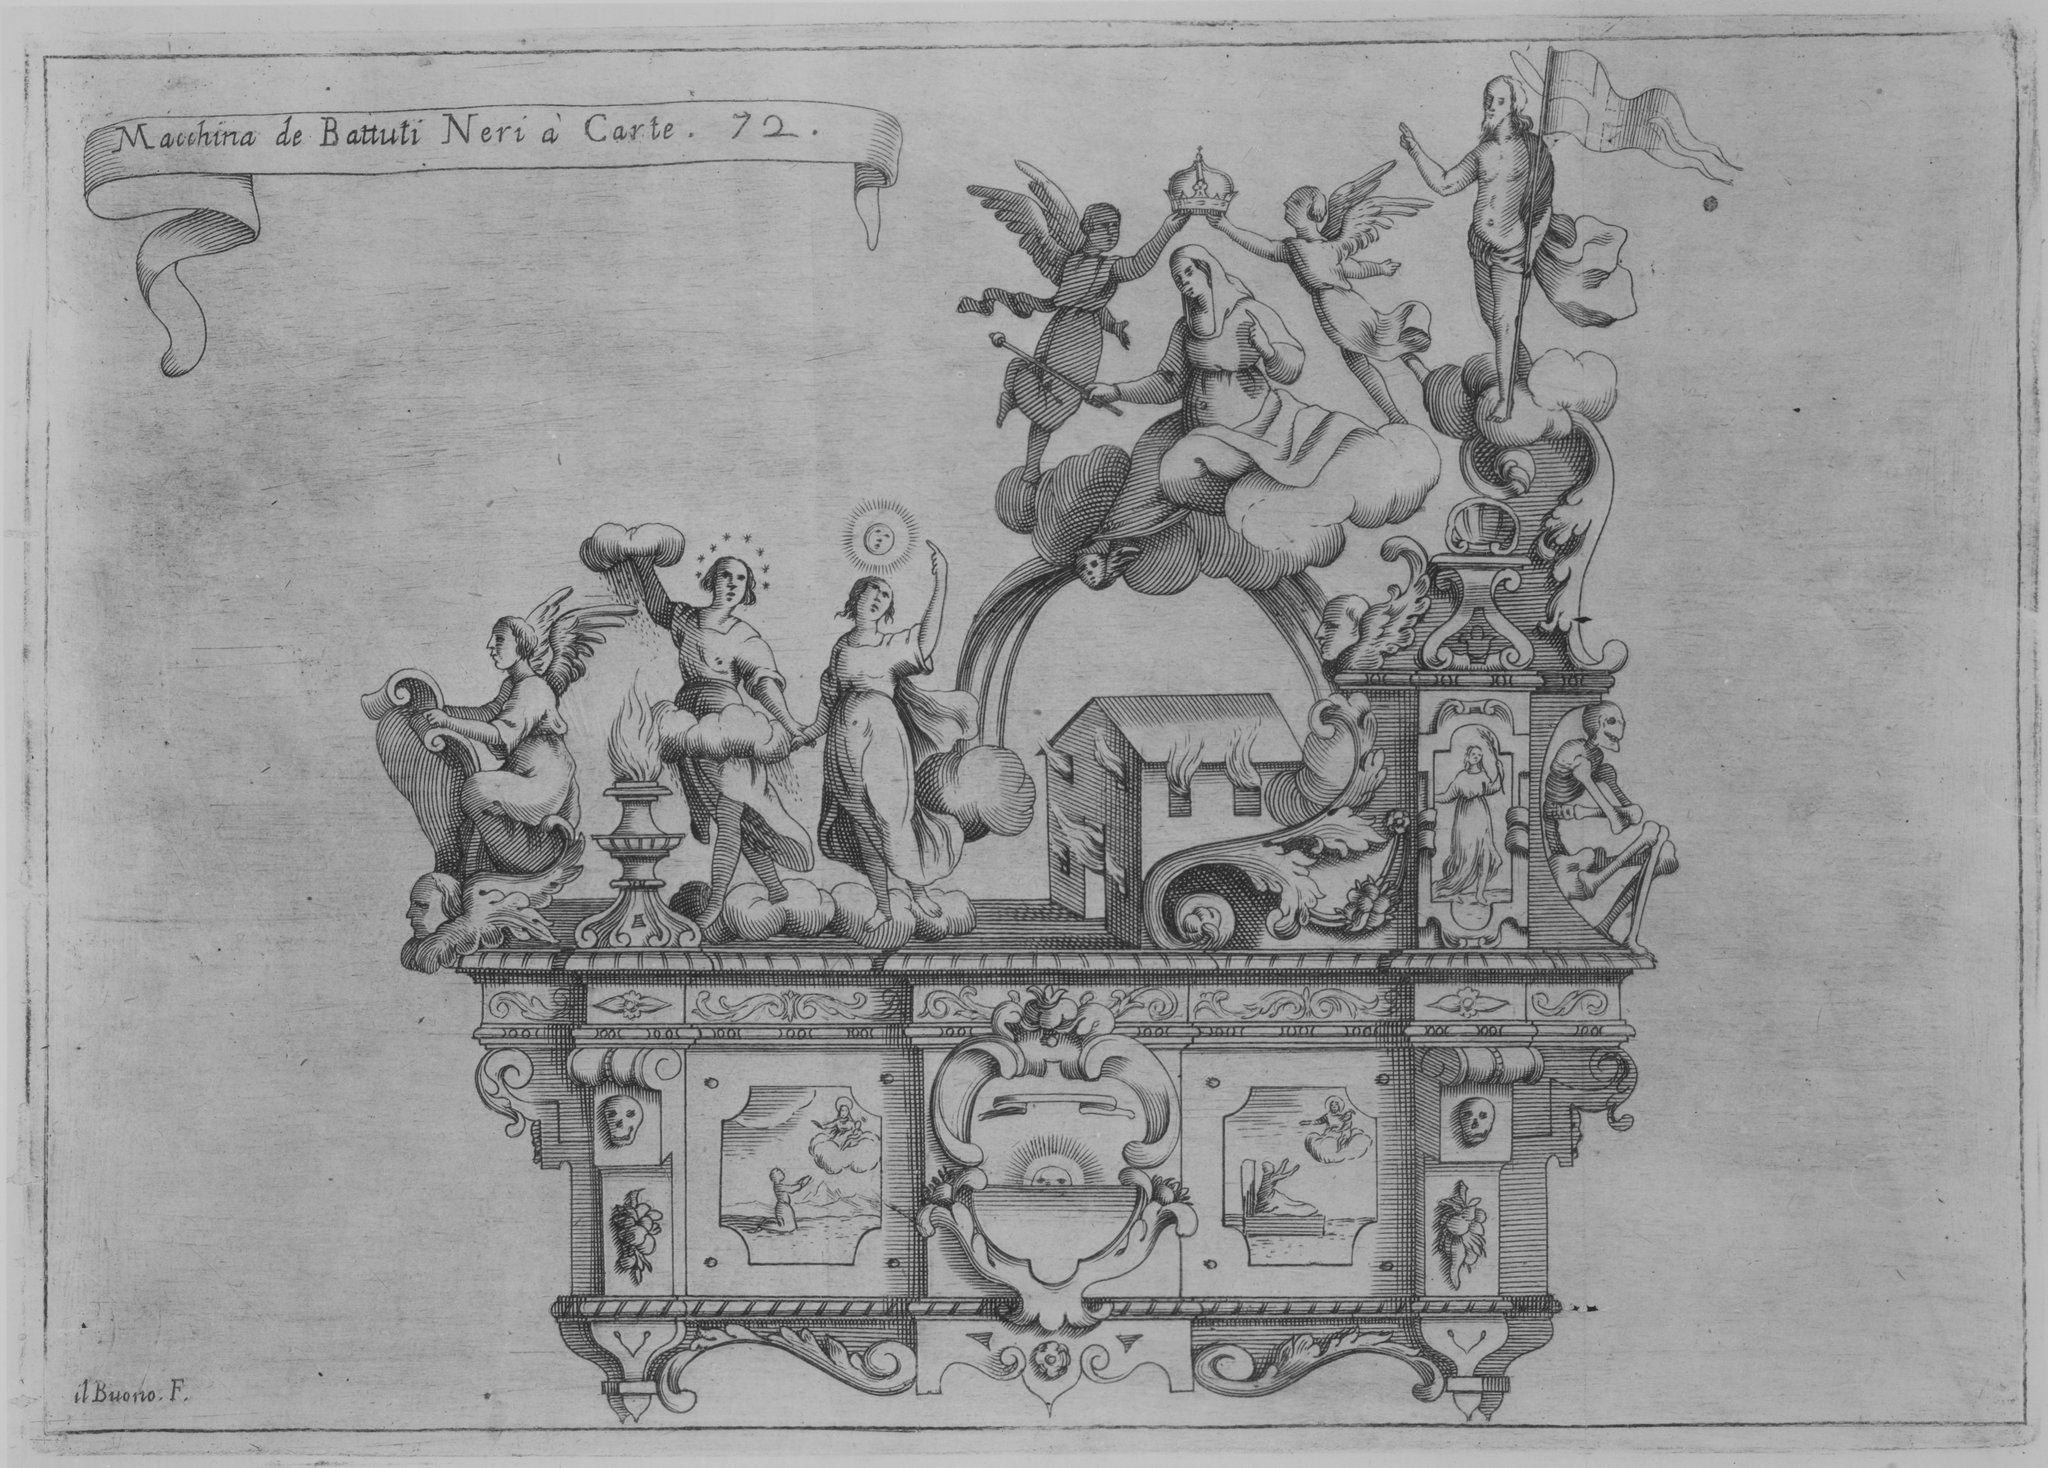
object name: print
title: Il Fuoco Trionfante...della Traslatione della Miracolo...La Madona Del Fuoco...li xx di Ottobre MDCXXXVI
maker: floriano dal buono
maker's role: artist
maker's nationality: italian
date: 1637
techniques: engraving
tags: skeletons,women,fire,angels